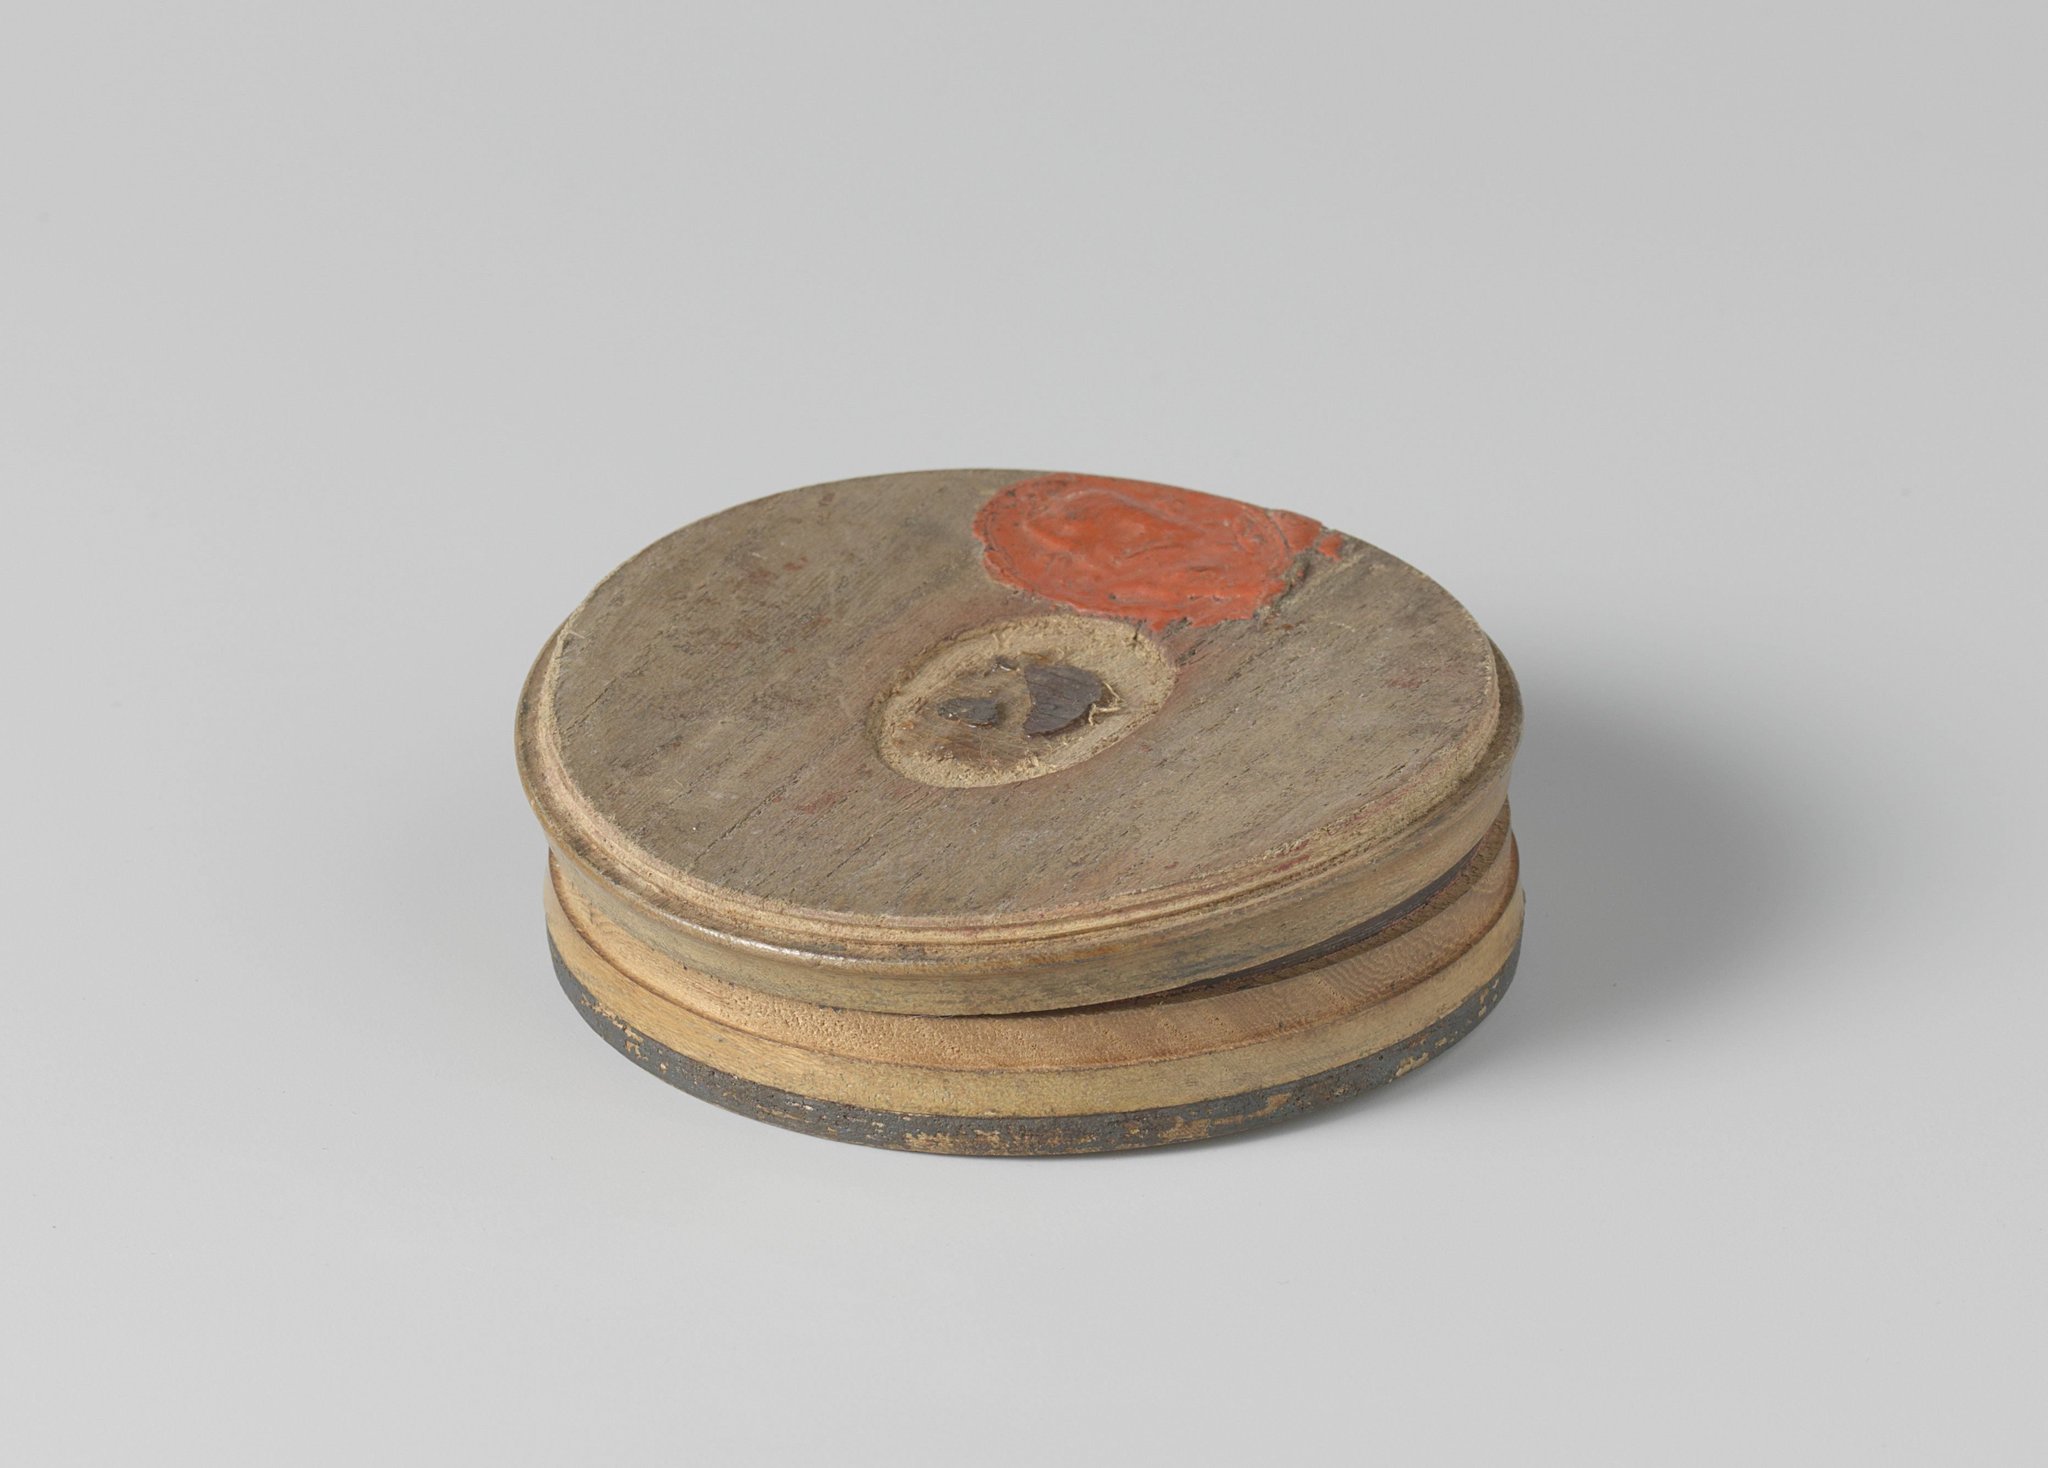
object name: snuffbox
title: Snuifdoos vervaardigd uit het hout van het schip van Van Speyk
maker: Anonymous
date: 1825-1831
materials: wood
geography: netherlands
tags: amsterdam, antwerp, jan van speyk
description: Gedraaid houten rond doosje met rood en zwart randje en van binnen rood/zwart/bruin schildpad (?). Snuifdoos gemaakt uit het hout van het schip van Van Speyk (Rood & zwart randje).